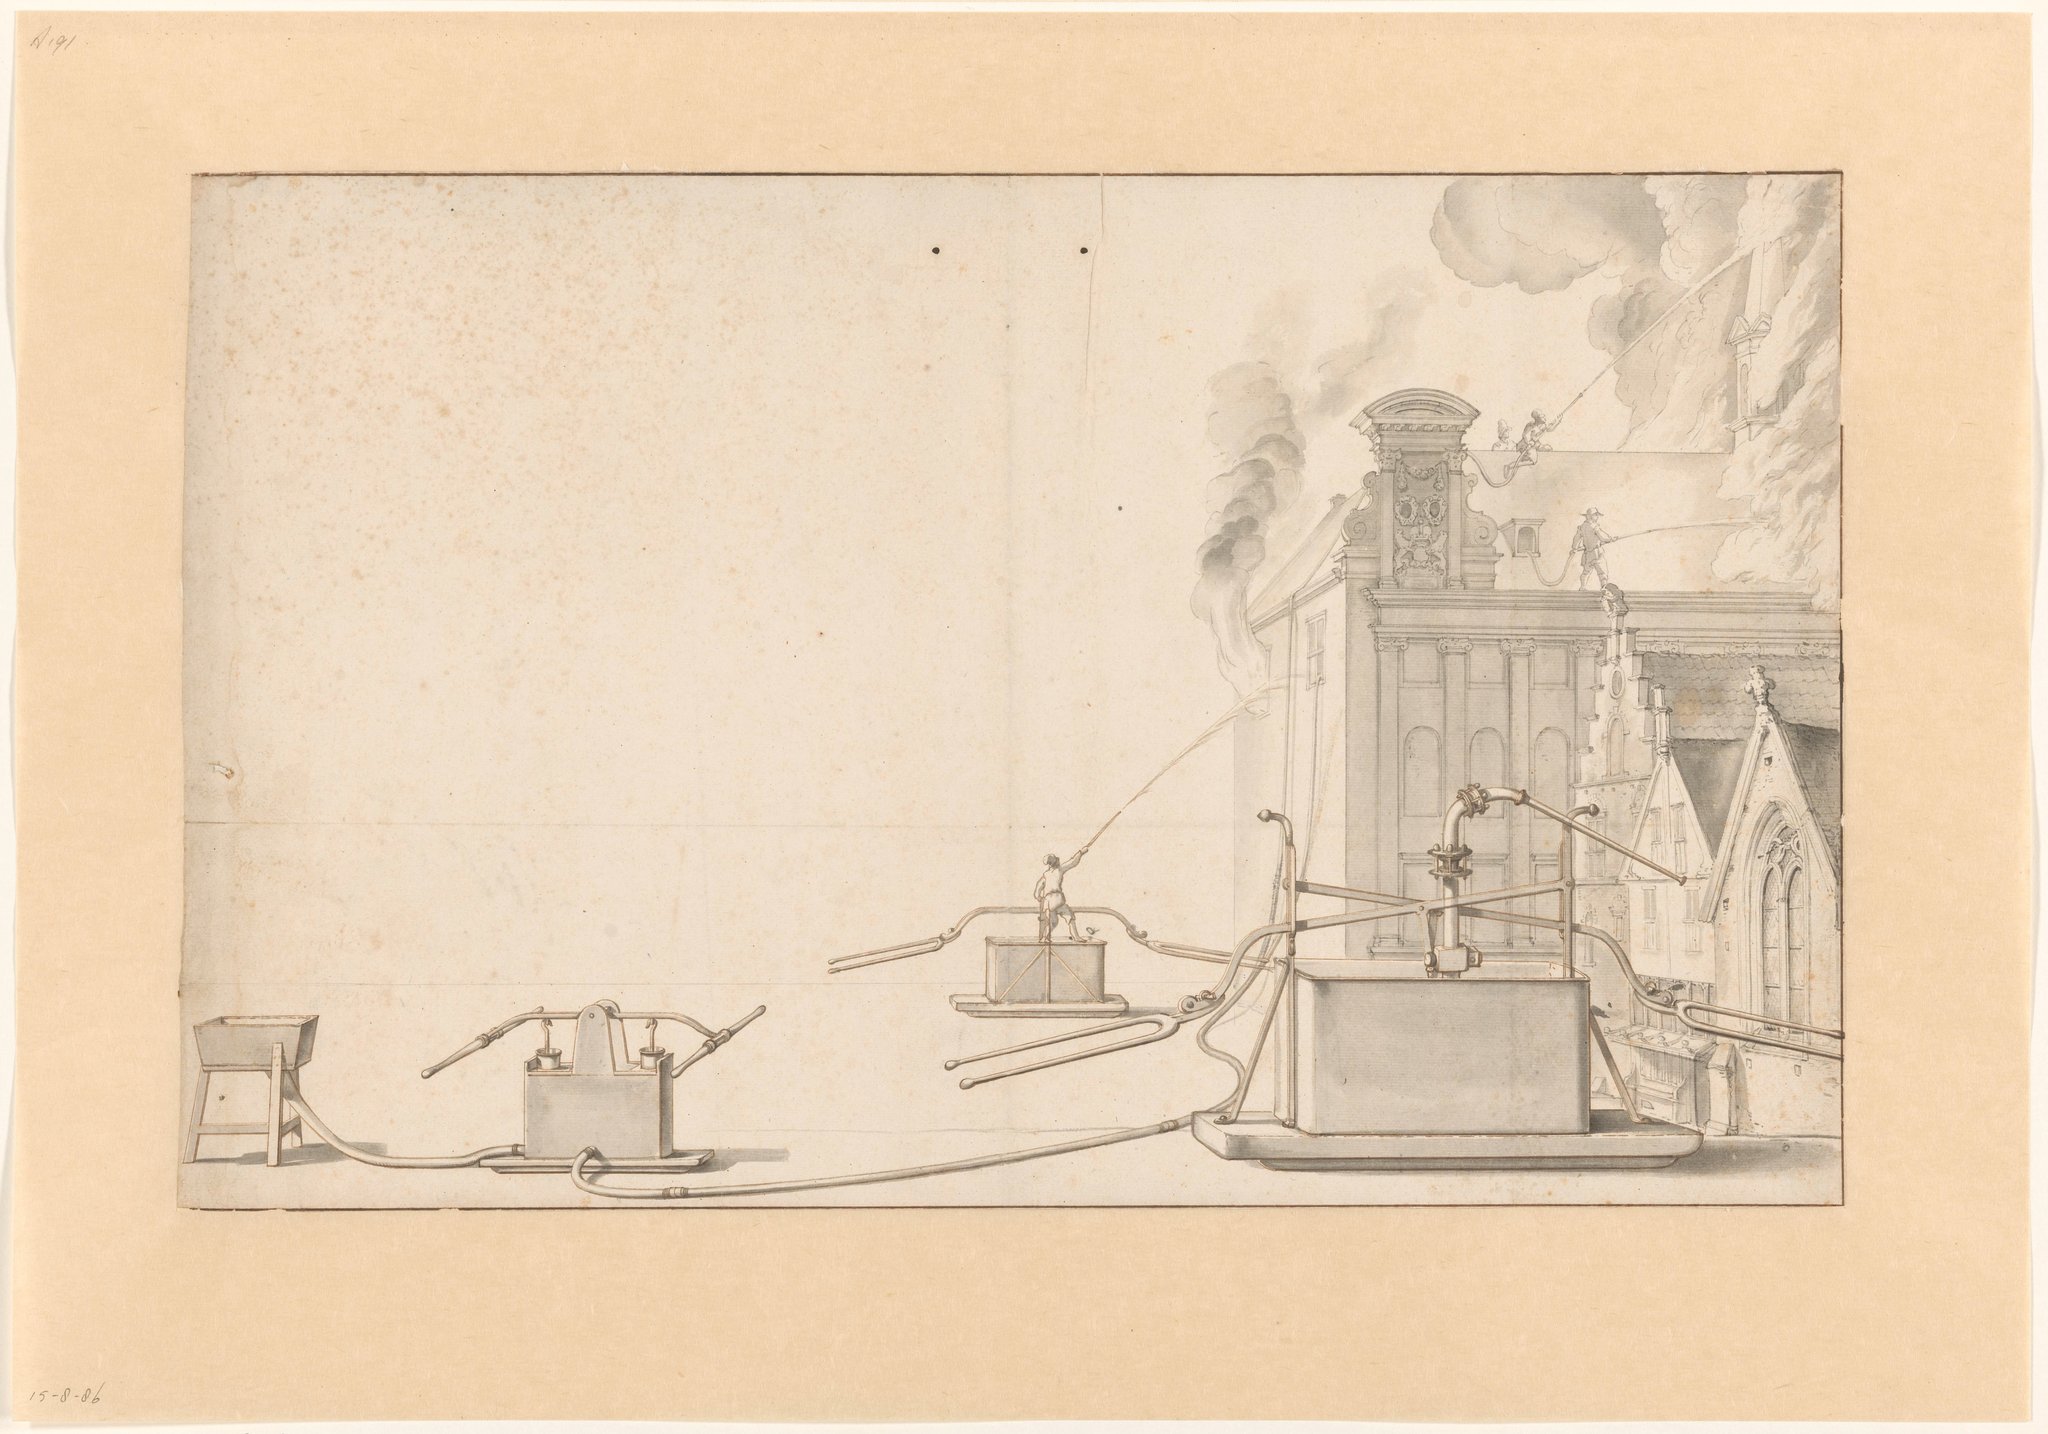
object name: drawing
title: Drie brandspuiten en een brandend gebouw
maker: jan van der heyden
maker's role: draughtsman, painter, print maker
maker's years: 1637-1712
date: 1680-1690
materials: ink, paper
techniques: brush, pen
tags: fire-fighting, pump (fire-extinguishing equipment), fire-hose